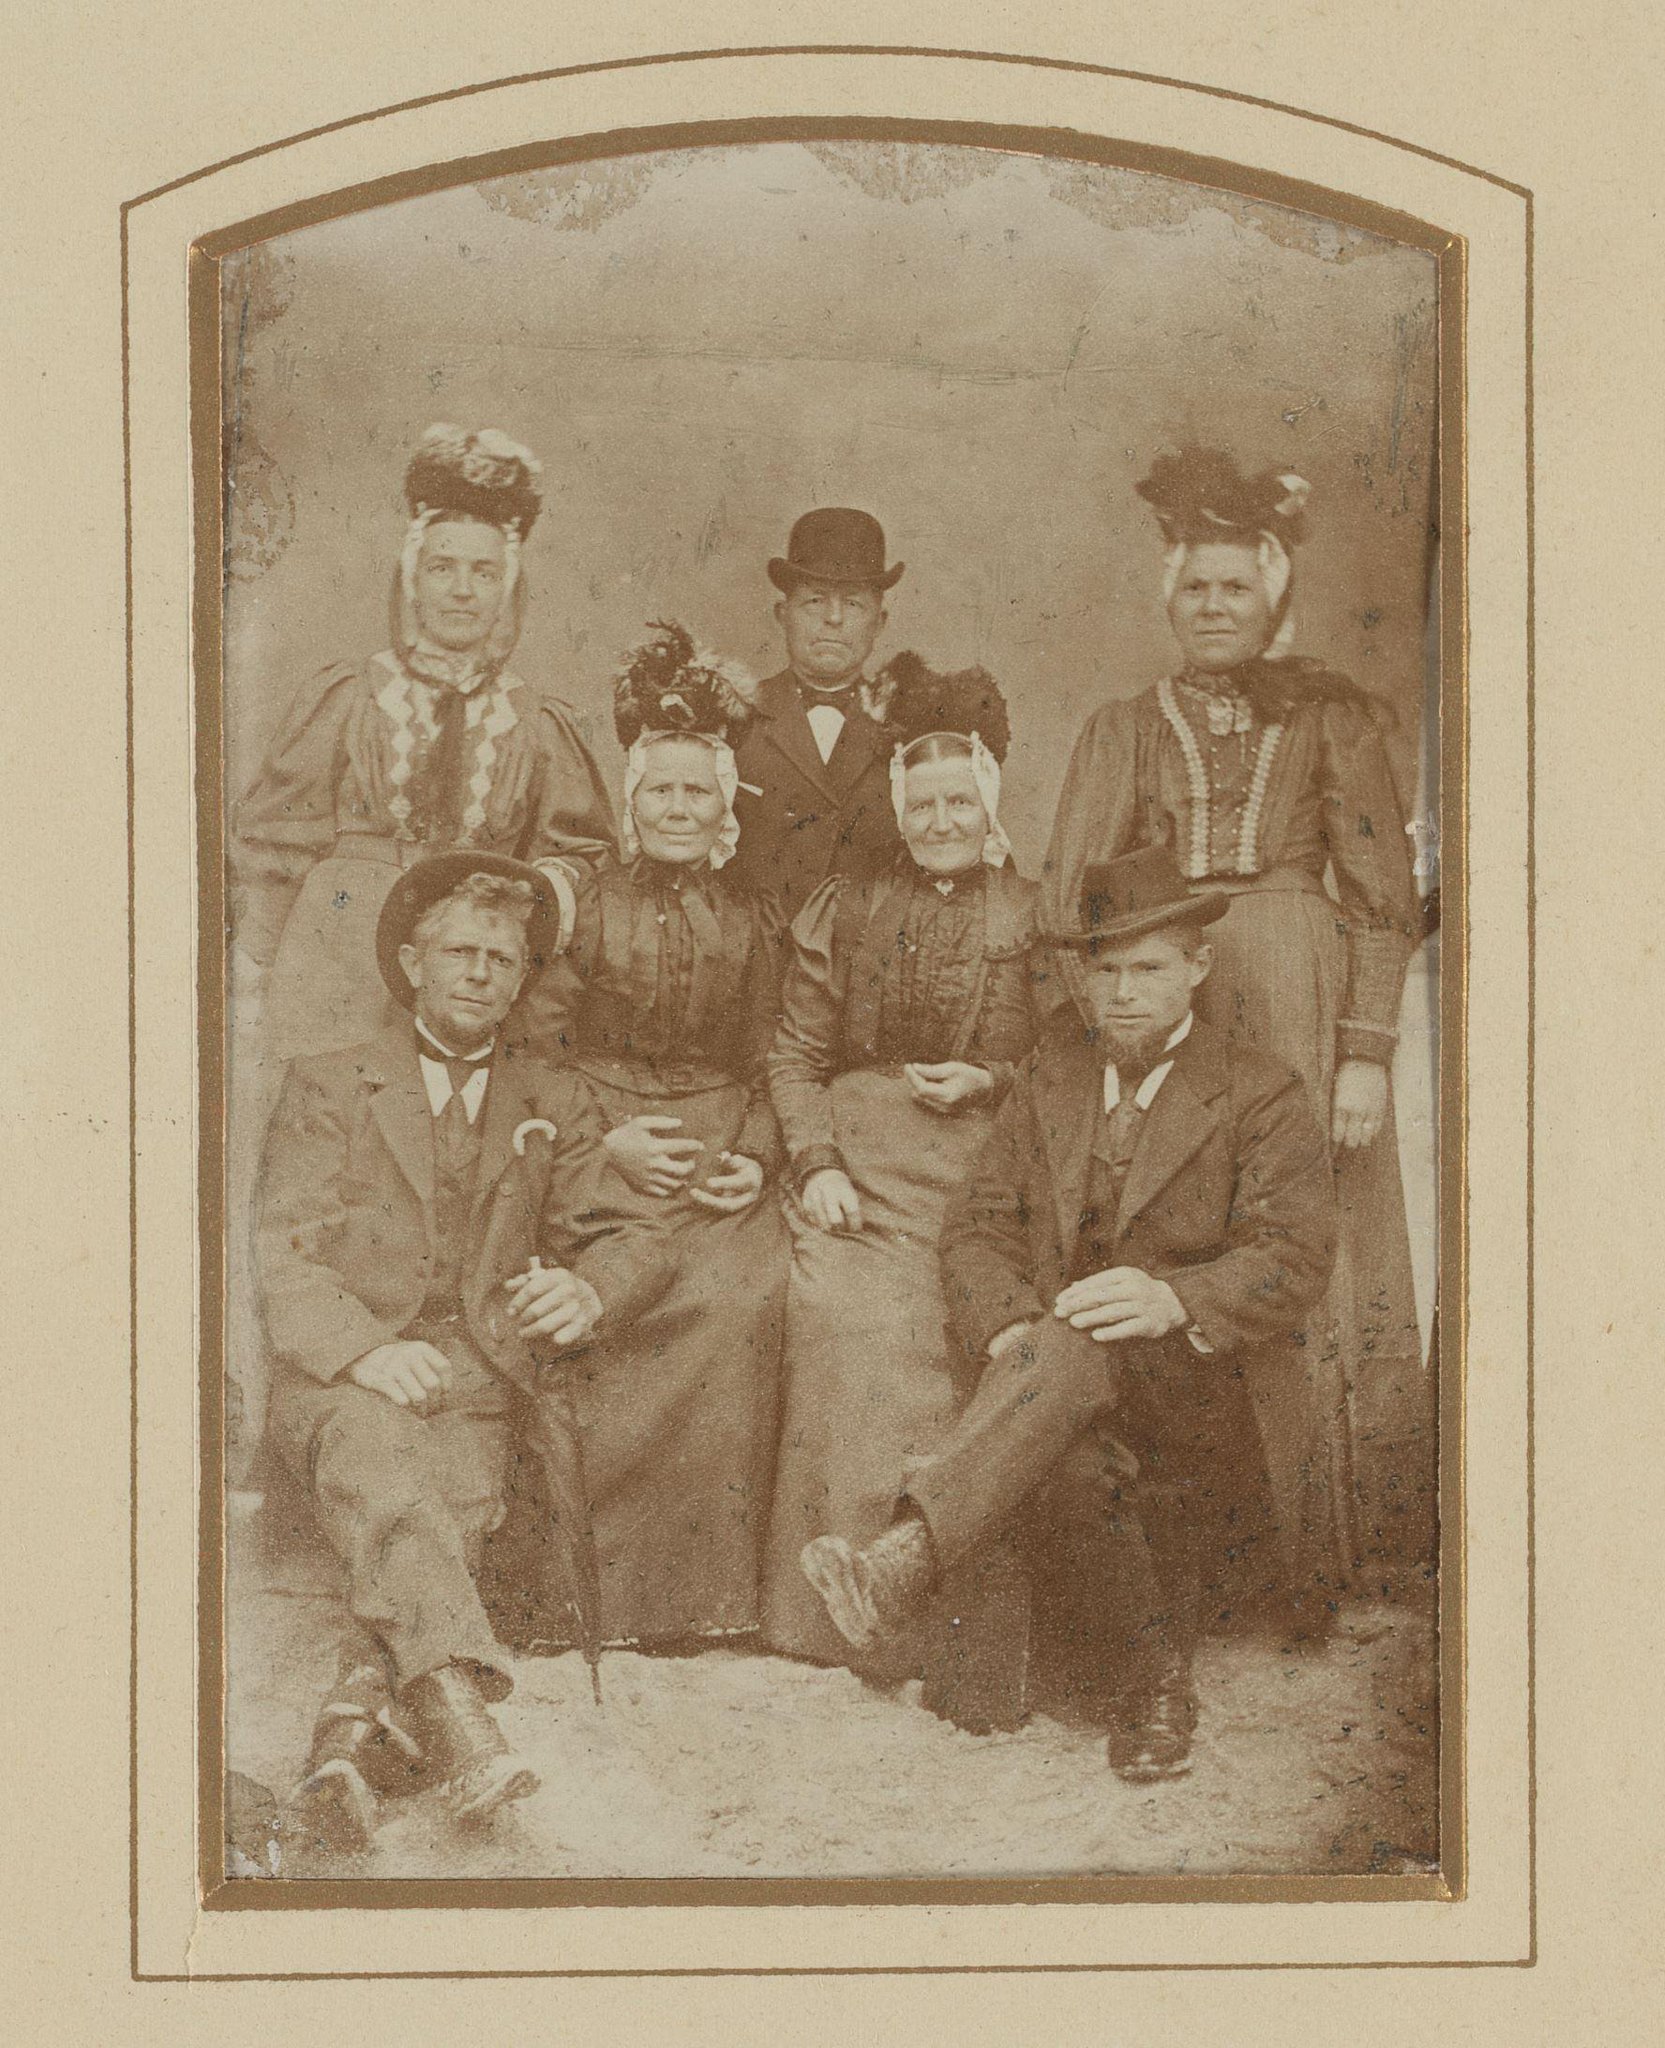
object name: cabinet photograph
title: Groepsportret van drie mannen en vier vrouwen in klederdracht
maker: josephus hendrikus petrus coppens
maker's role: fotograaf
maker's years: 1864-1941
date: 1889-1925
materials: cardboard, photographic support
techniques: collodion silver print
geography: purmerend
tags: adult man (+ three persons), adult woman (+ four persons), folk costume, regional costume, anonymous historical persons portrayed in a group, in a group-portrait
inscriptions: inscription: ‘J.H.P. Coppens - Purmerend.’